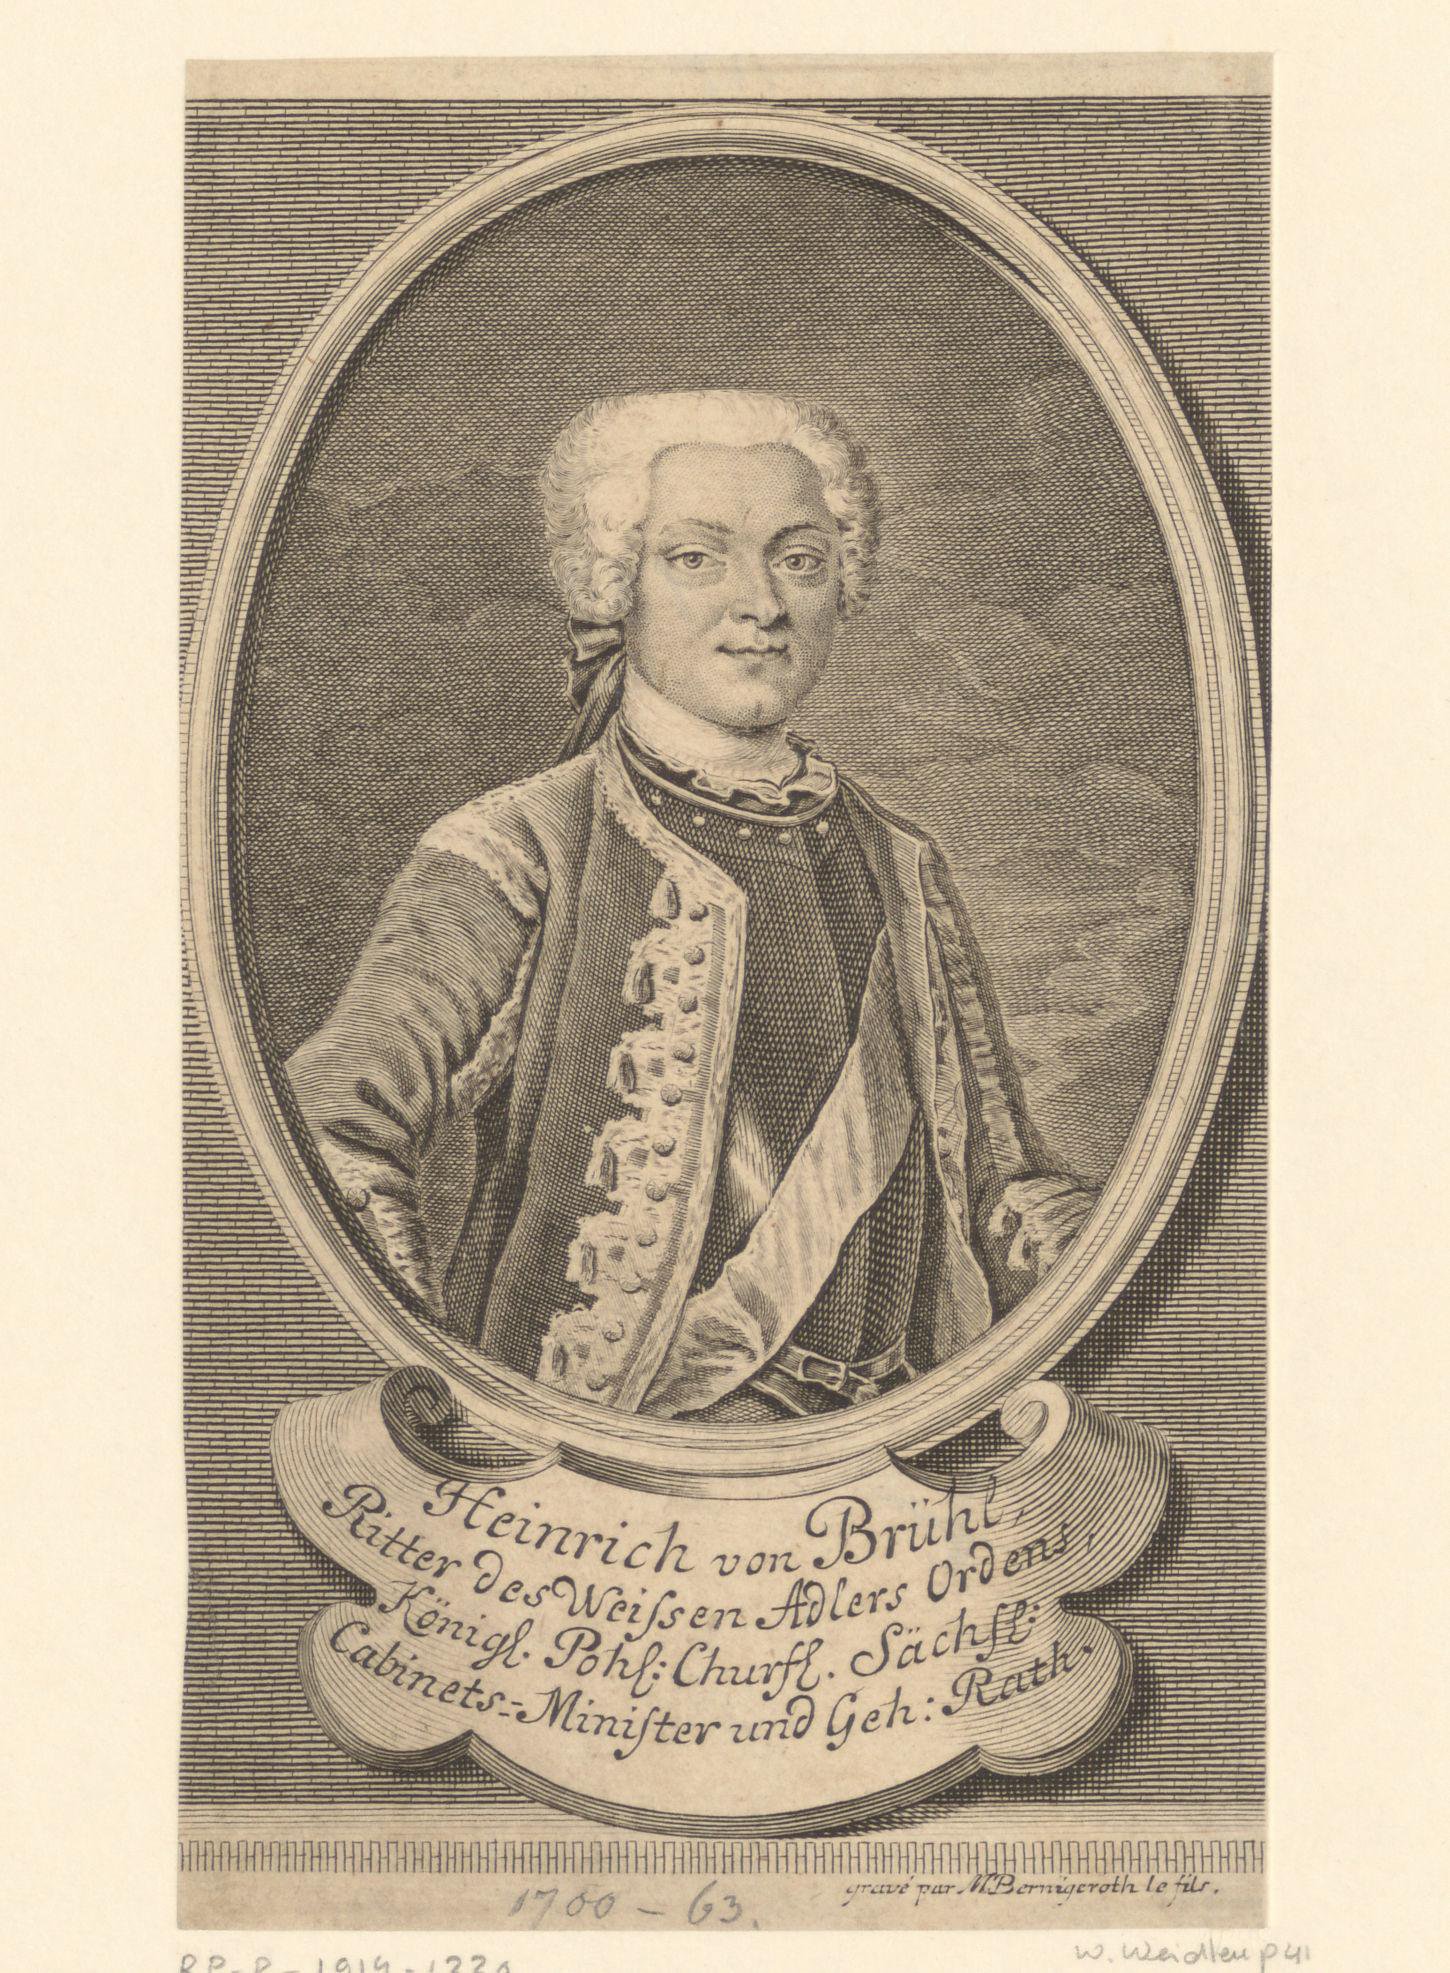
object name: print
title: Portret van Heinrich von Brühl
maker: johann martin bernigeroth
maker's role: print maker, publisher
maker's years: 1713-1767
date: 1734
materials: paper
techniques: engraving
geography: leipzig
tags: heinrich von brühl, historical persons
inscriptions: collector's mark: Lugt 2228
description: Prent ook gebruikt in: Die Europäische Fama, Welche den gegenwärtigen Zustand der vornehmsten Höfe entdecket. dl. 351. Leipzig: Gleditsch, 1734.